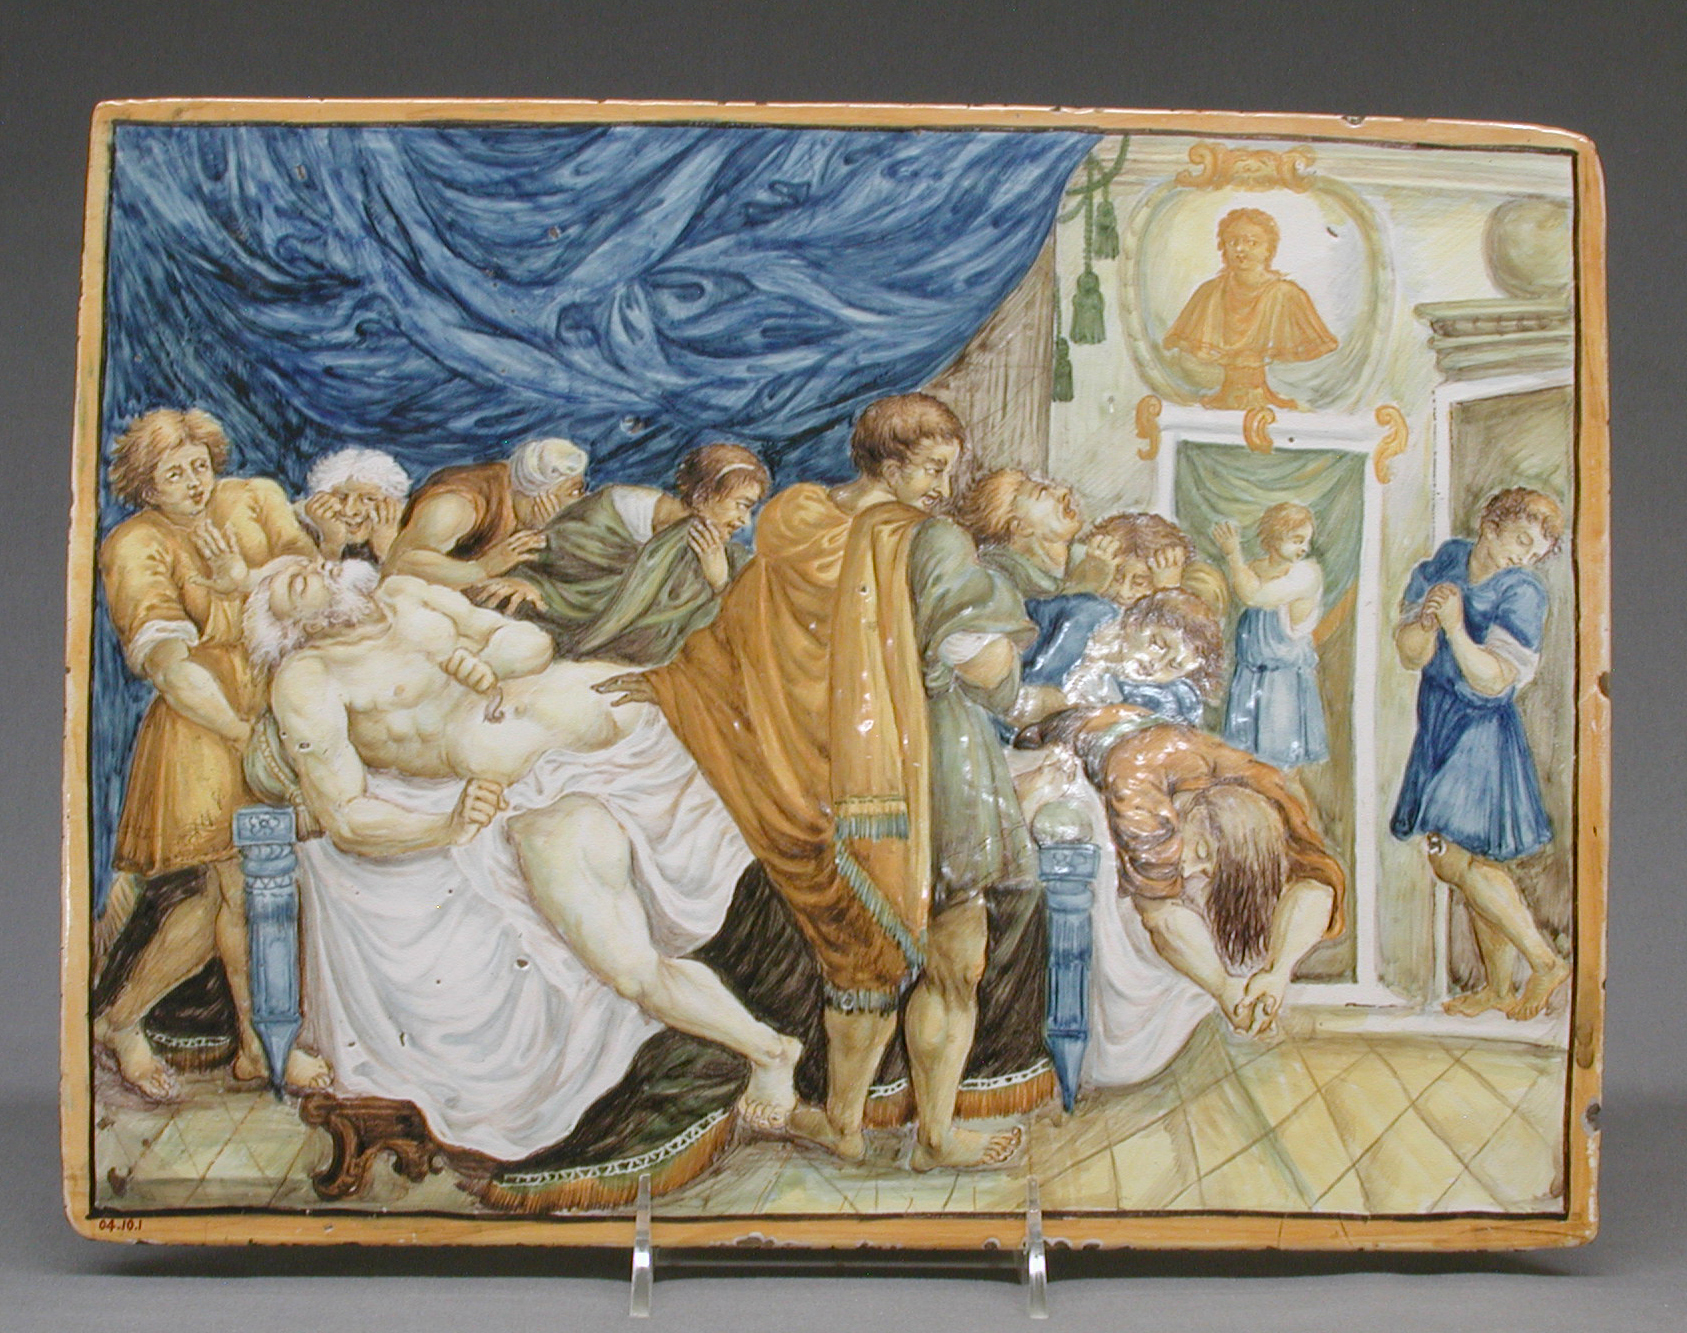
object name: plaque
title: Death of Cato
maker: berardino gentile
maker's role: maker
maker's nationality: italian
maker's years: 1727-1813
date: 1767-1800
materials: earthenware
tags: sadness,men,death